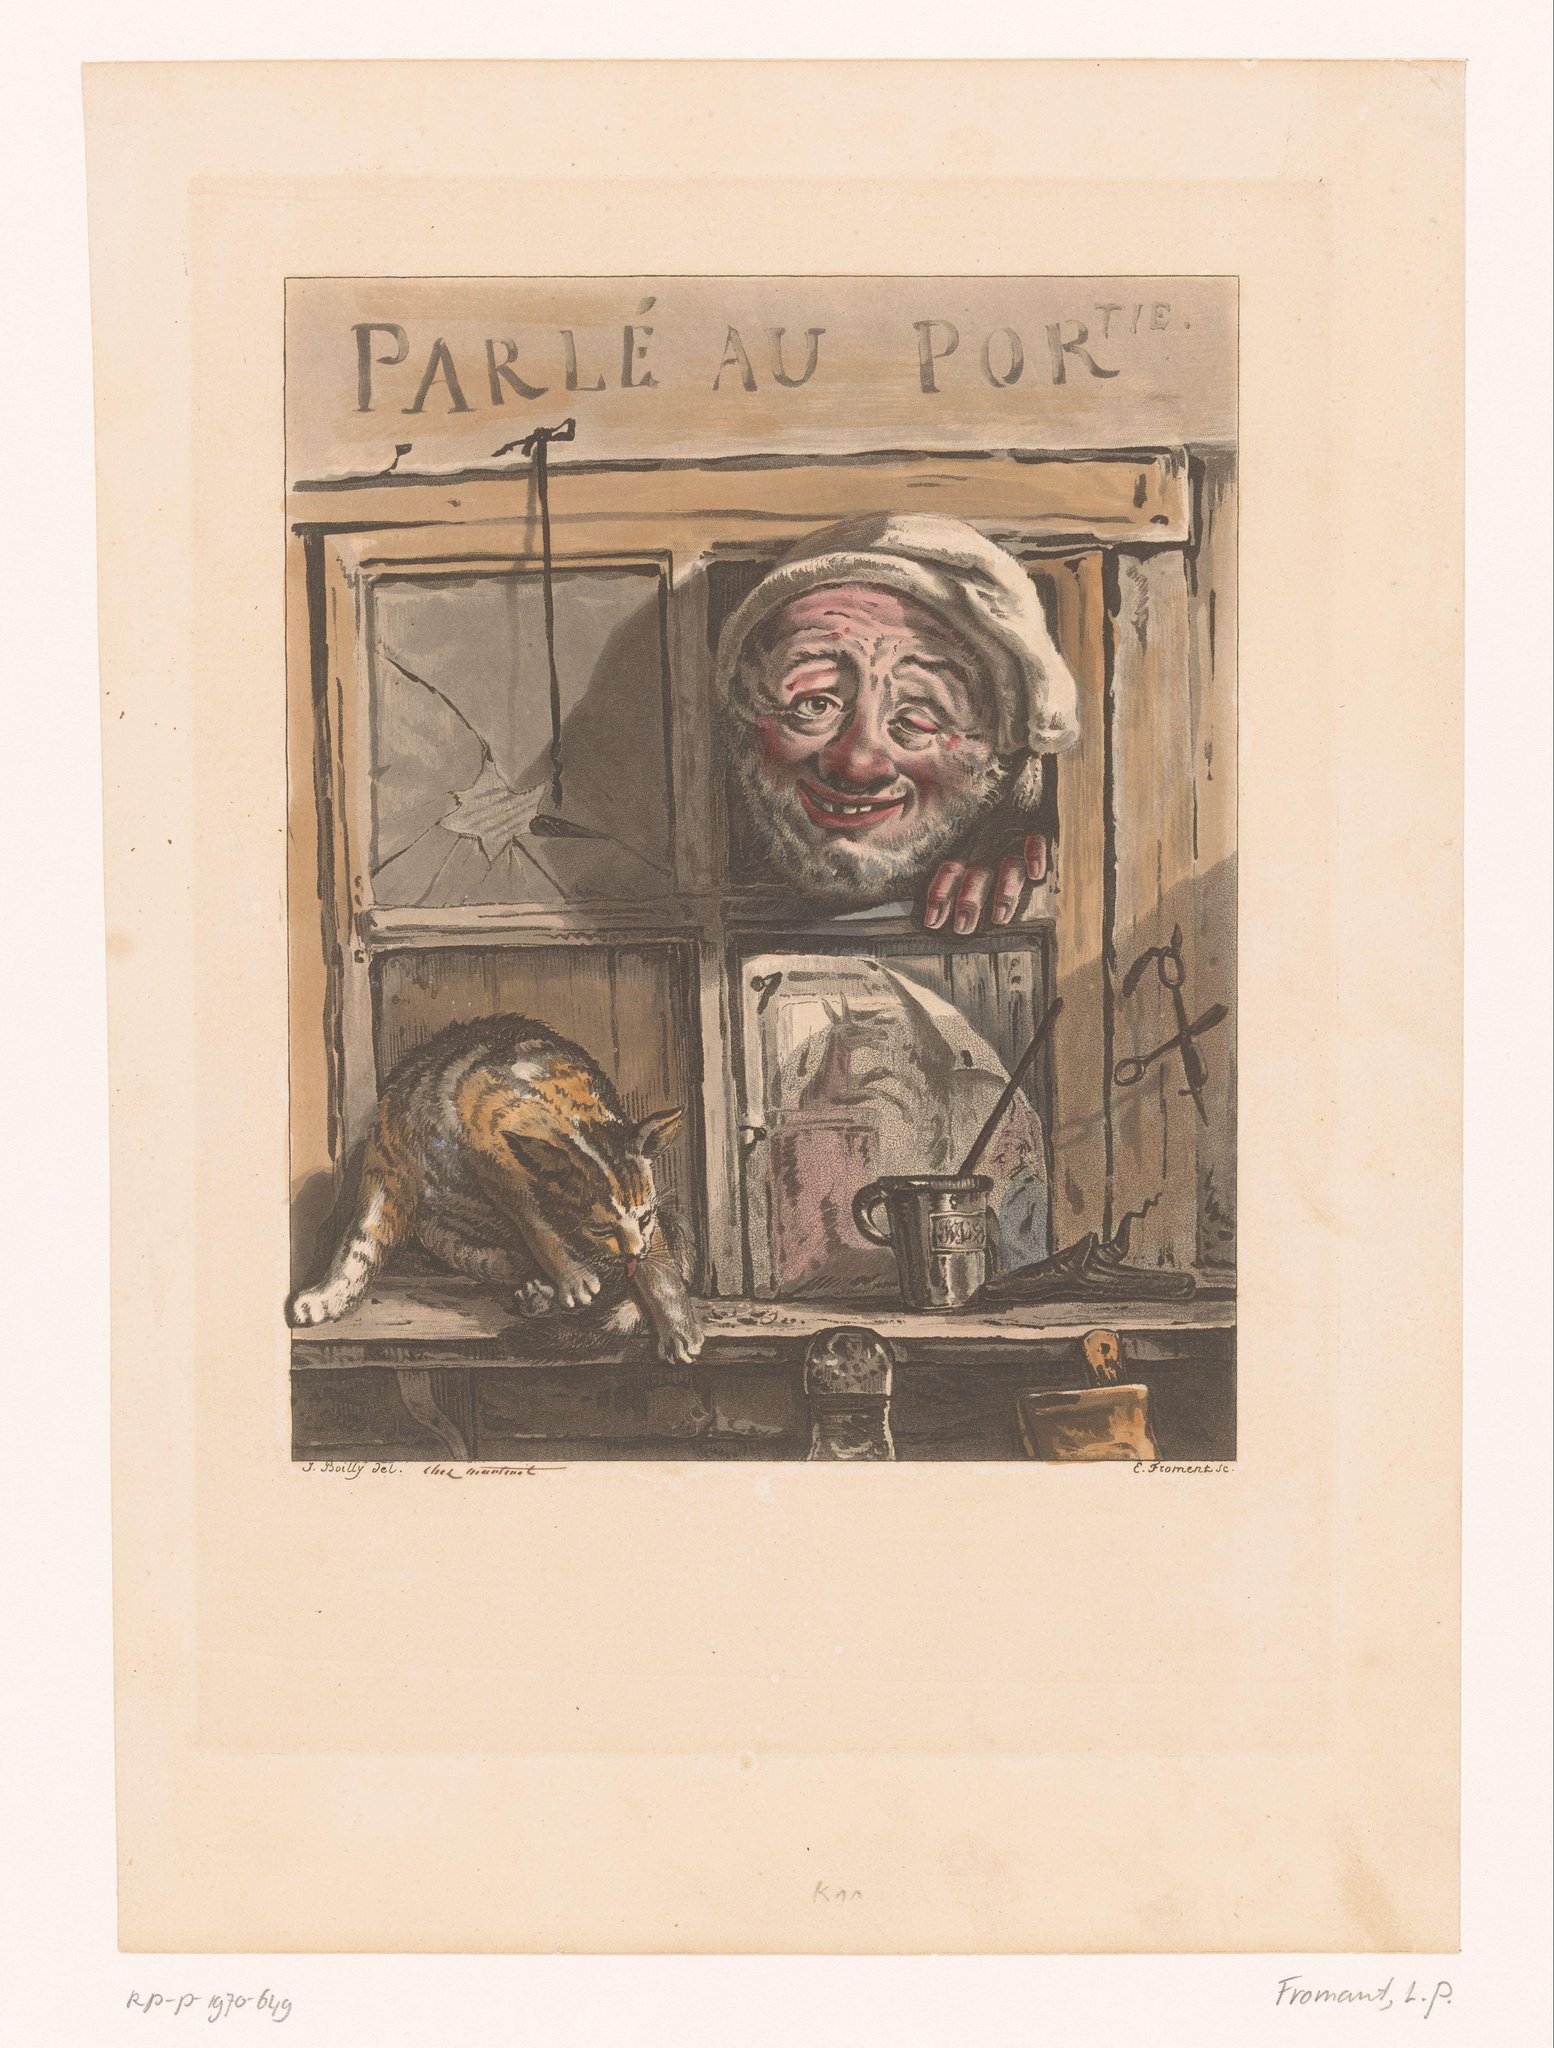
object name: print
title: Dronken portier met kat bij het raam van een café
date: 1815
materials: paper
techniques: hand coloring, lithograph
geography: paris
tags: house-guard, doorkeeper, janitor, cat, inn, coffee-house, public house, etc., open window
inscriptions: collector's mark: Lugt 2228a